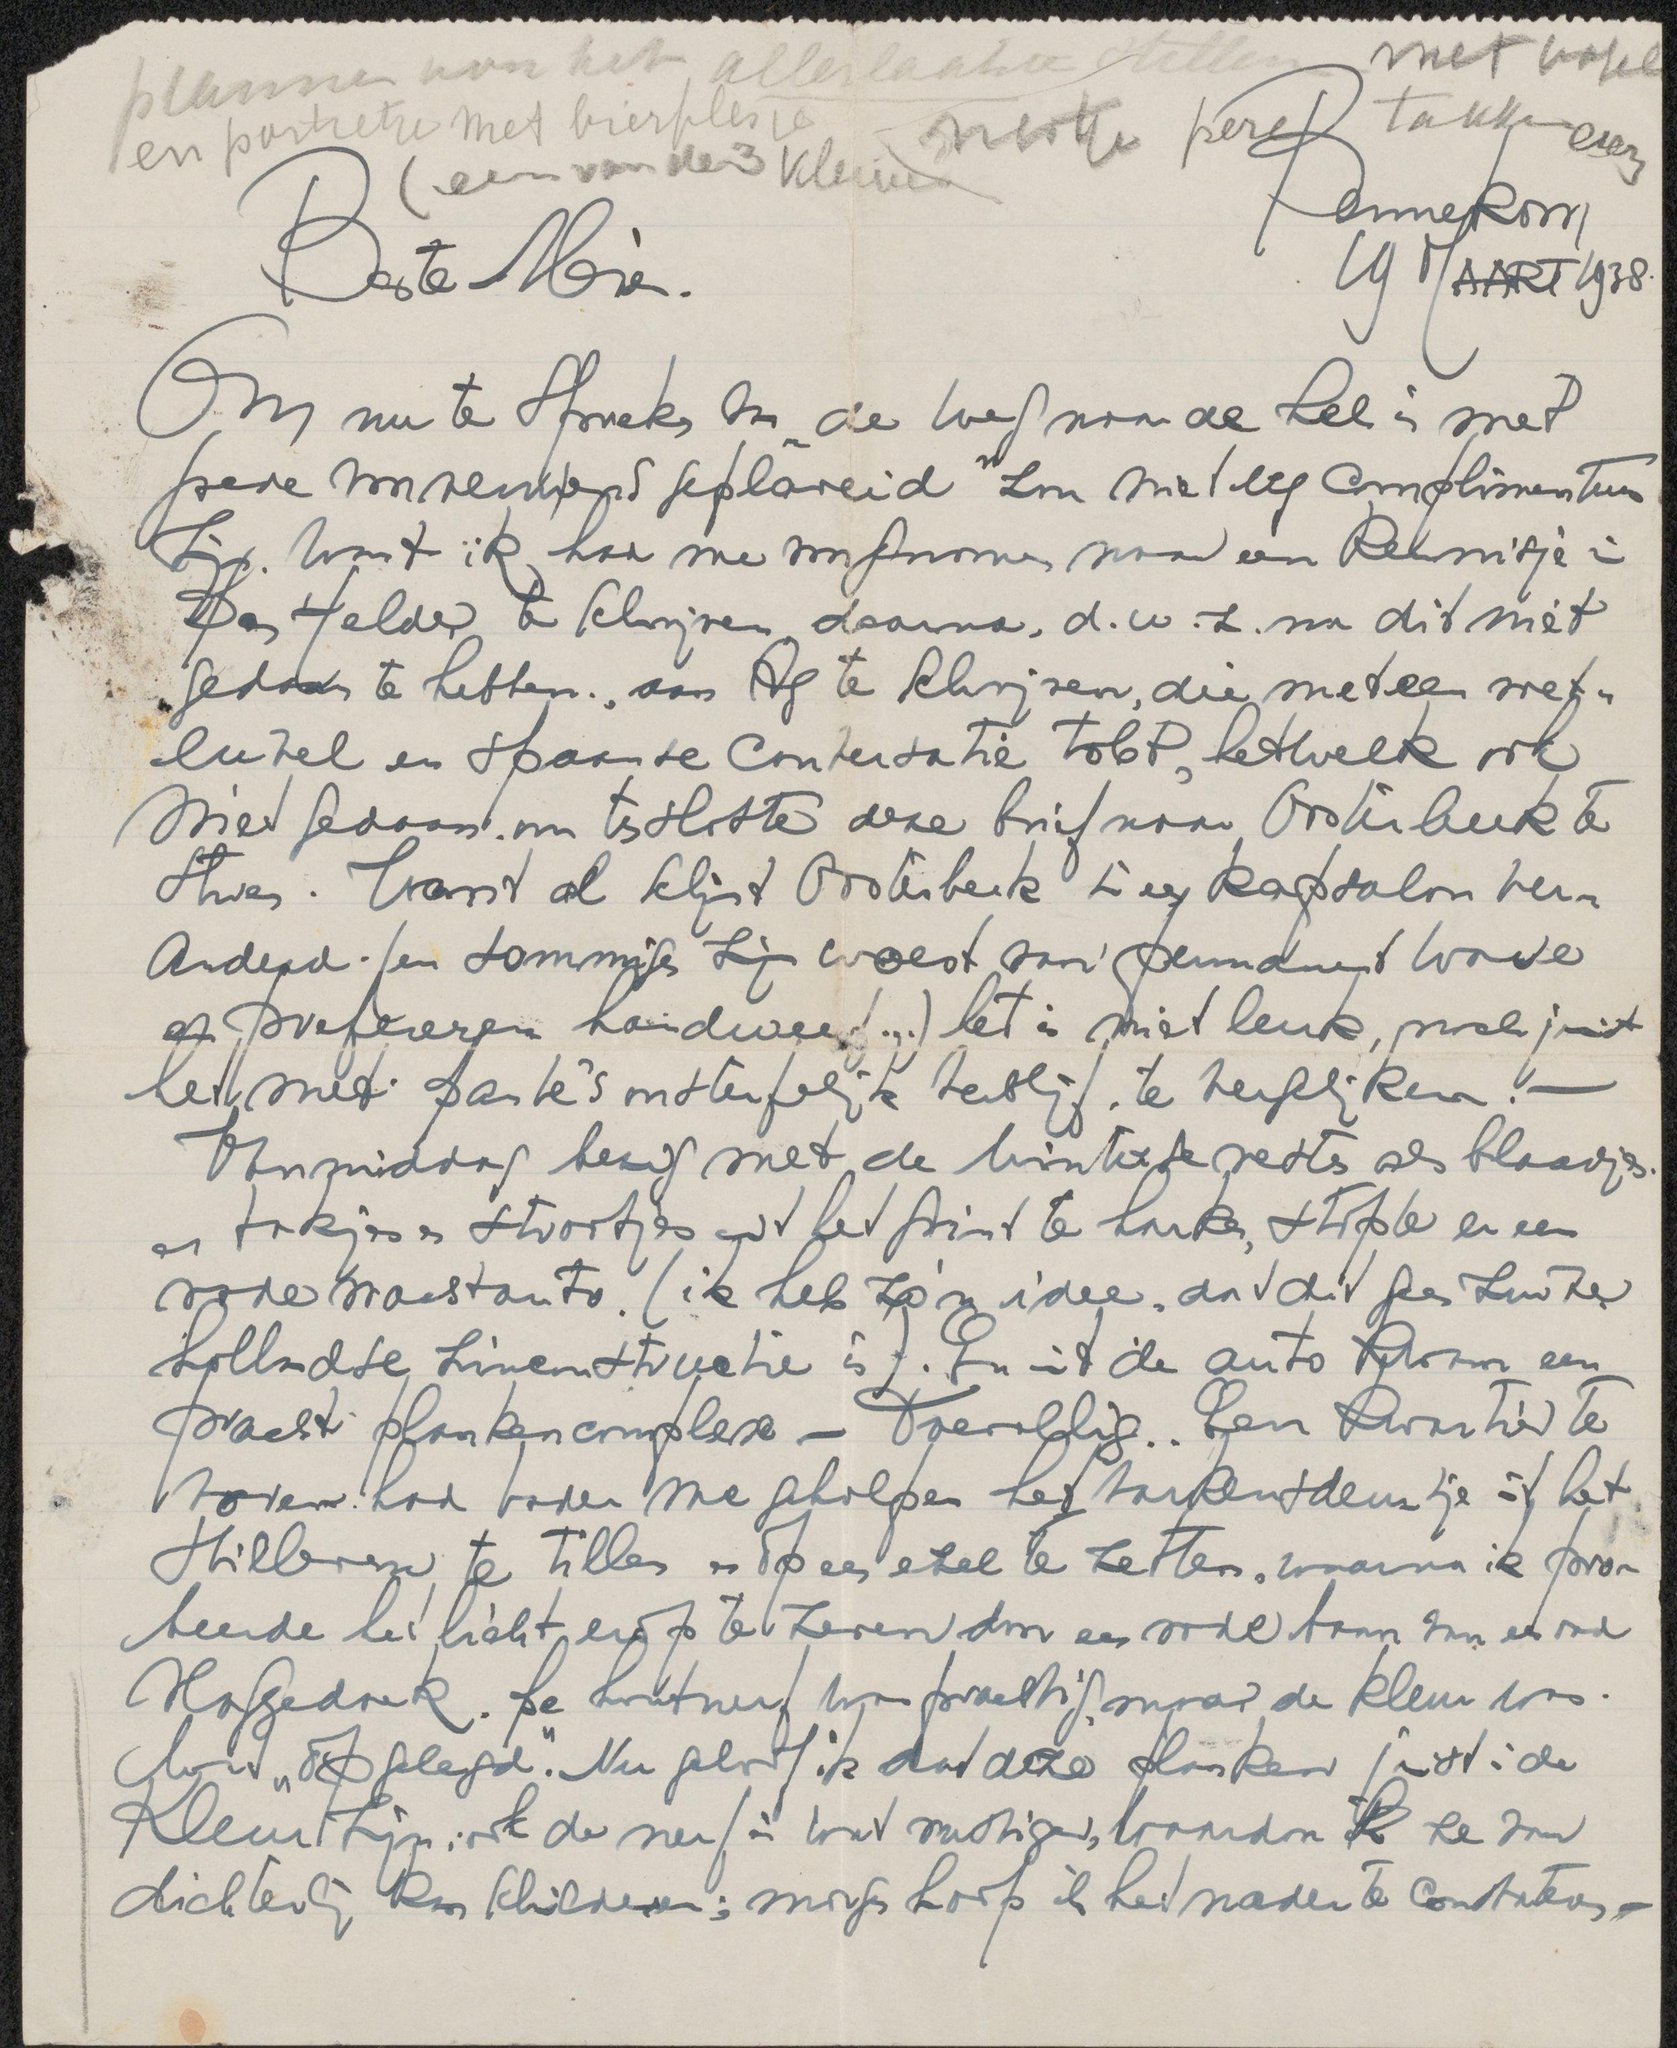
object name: letter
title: Brief aan Mien Cambier van Nooten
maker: dick ket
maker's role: draughtsman, print maker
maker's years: 1902-1940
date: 1938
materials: ink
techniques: pen, writing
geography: bennekom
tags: grave, arnhem, mien cambier van nooten, painting (including book-illumination, miniature-painting), workshop, studio of the artist (in general)